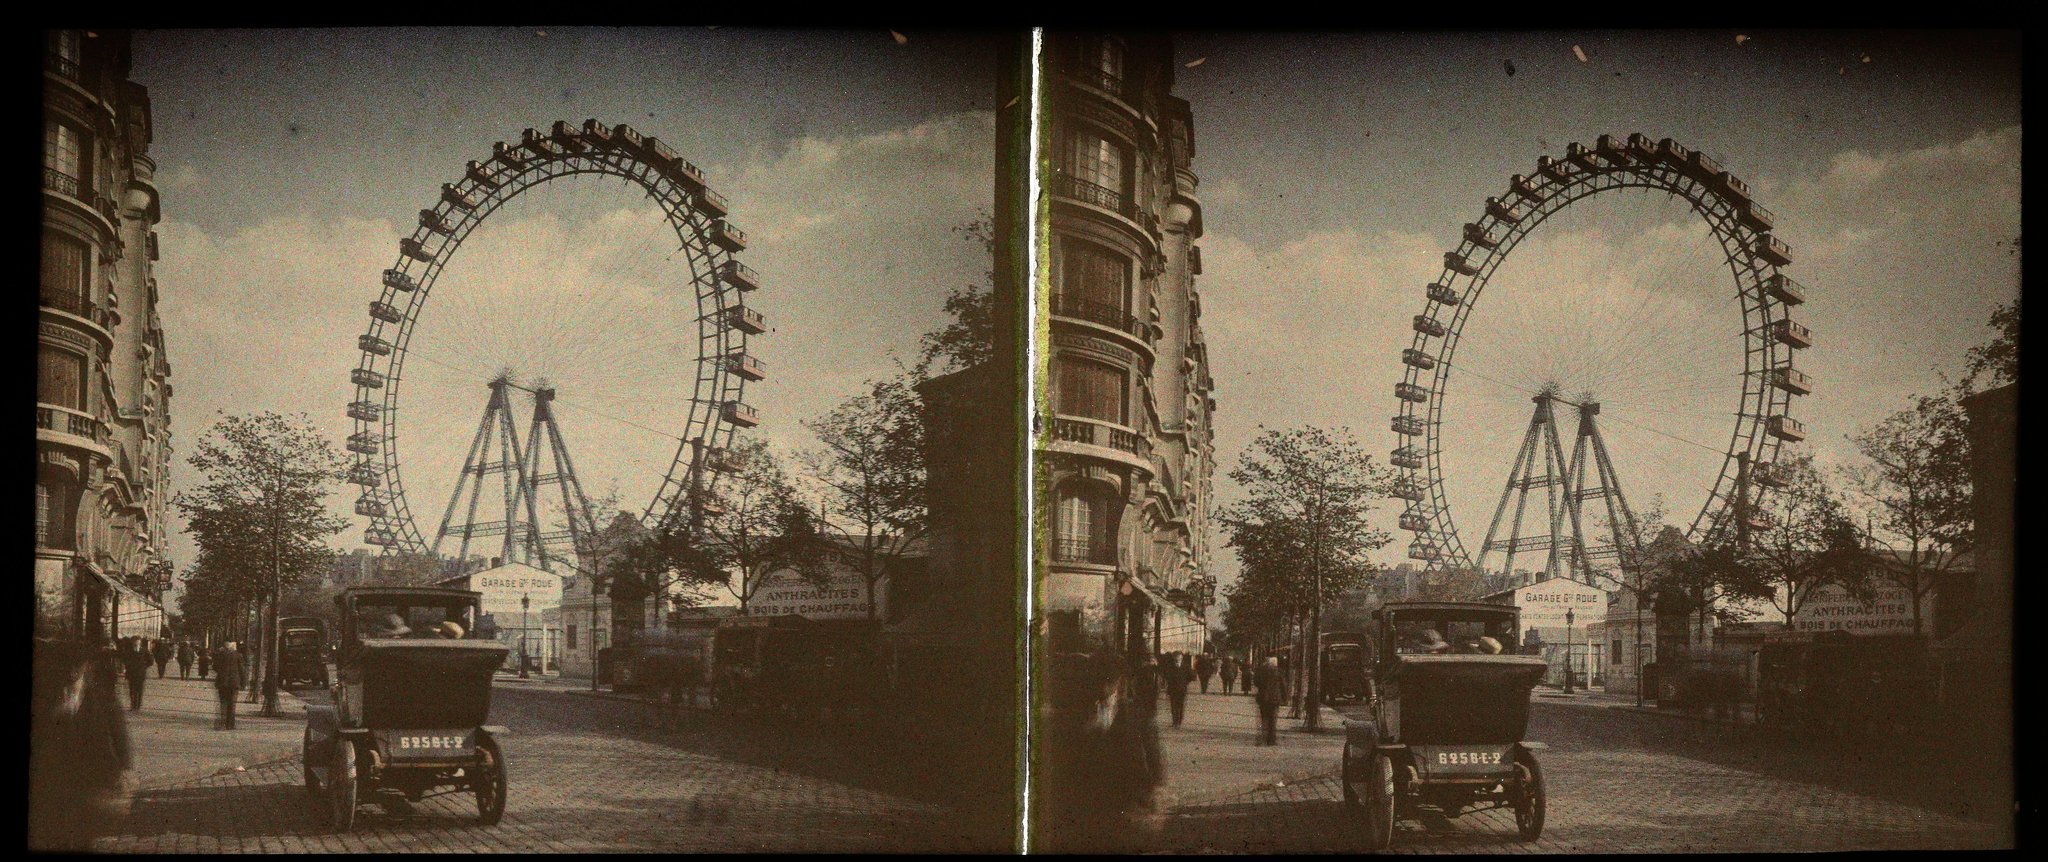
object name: stereograph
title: Kermis met reuzenrad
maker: Anonymous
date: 1900-1940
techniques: autochrome process